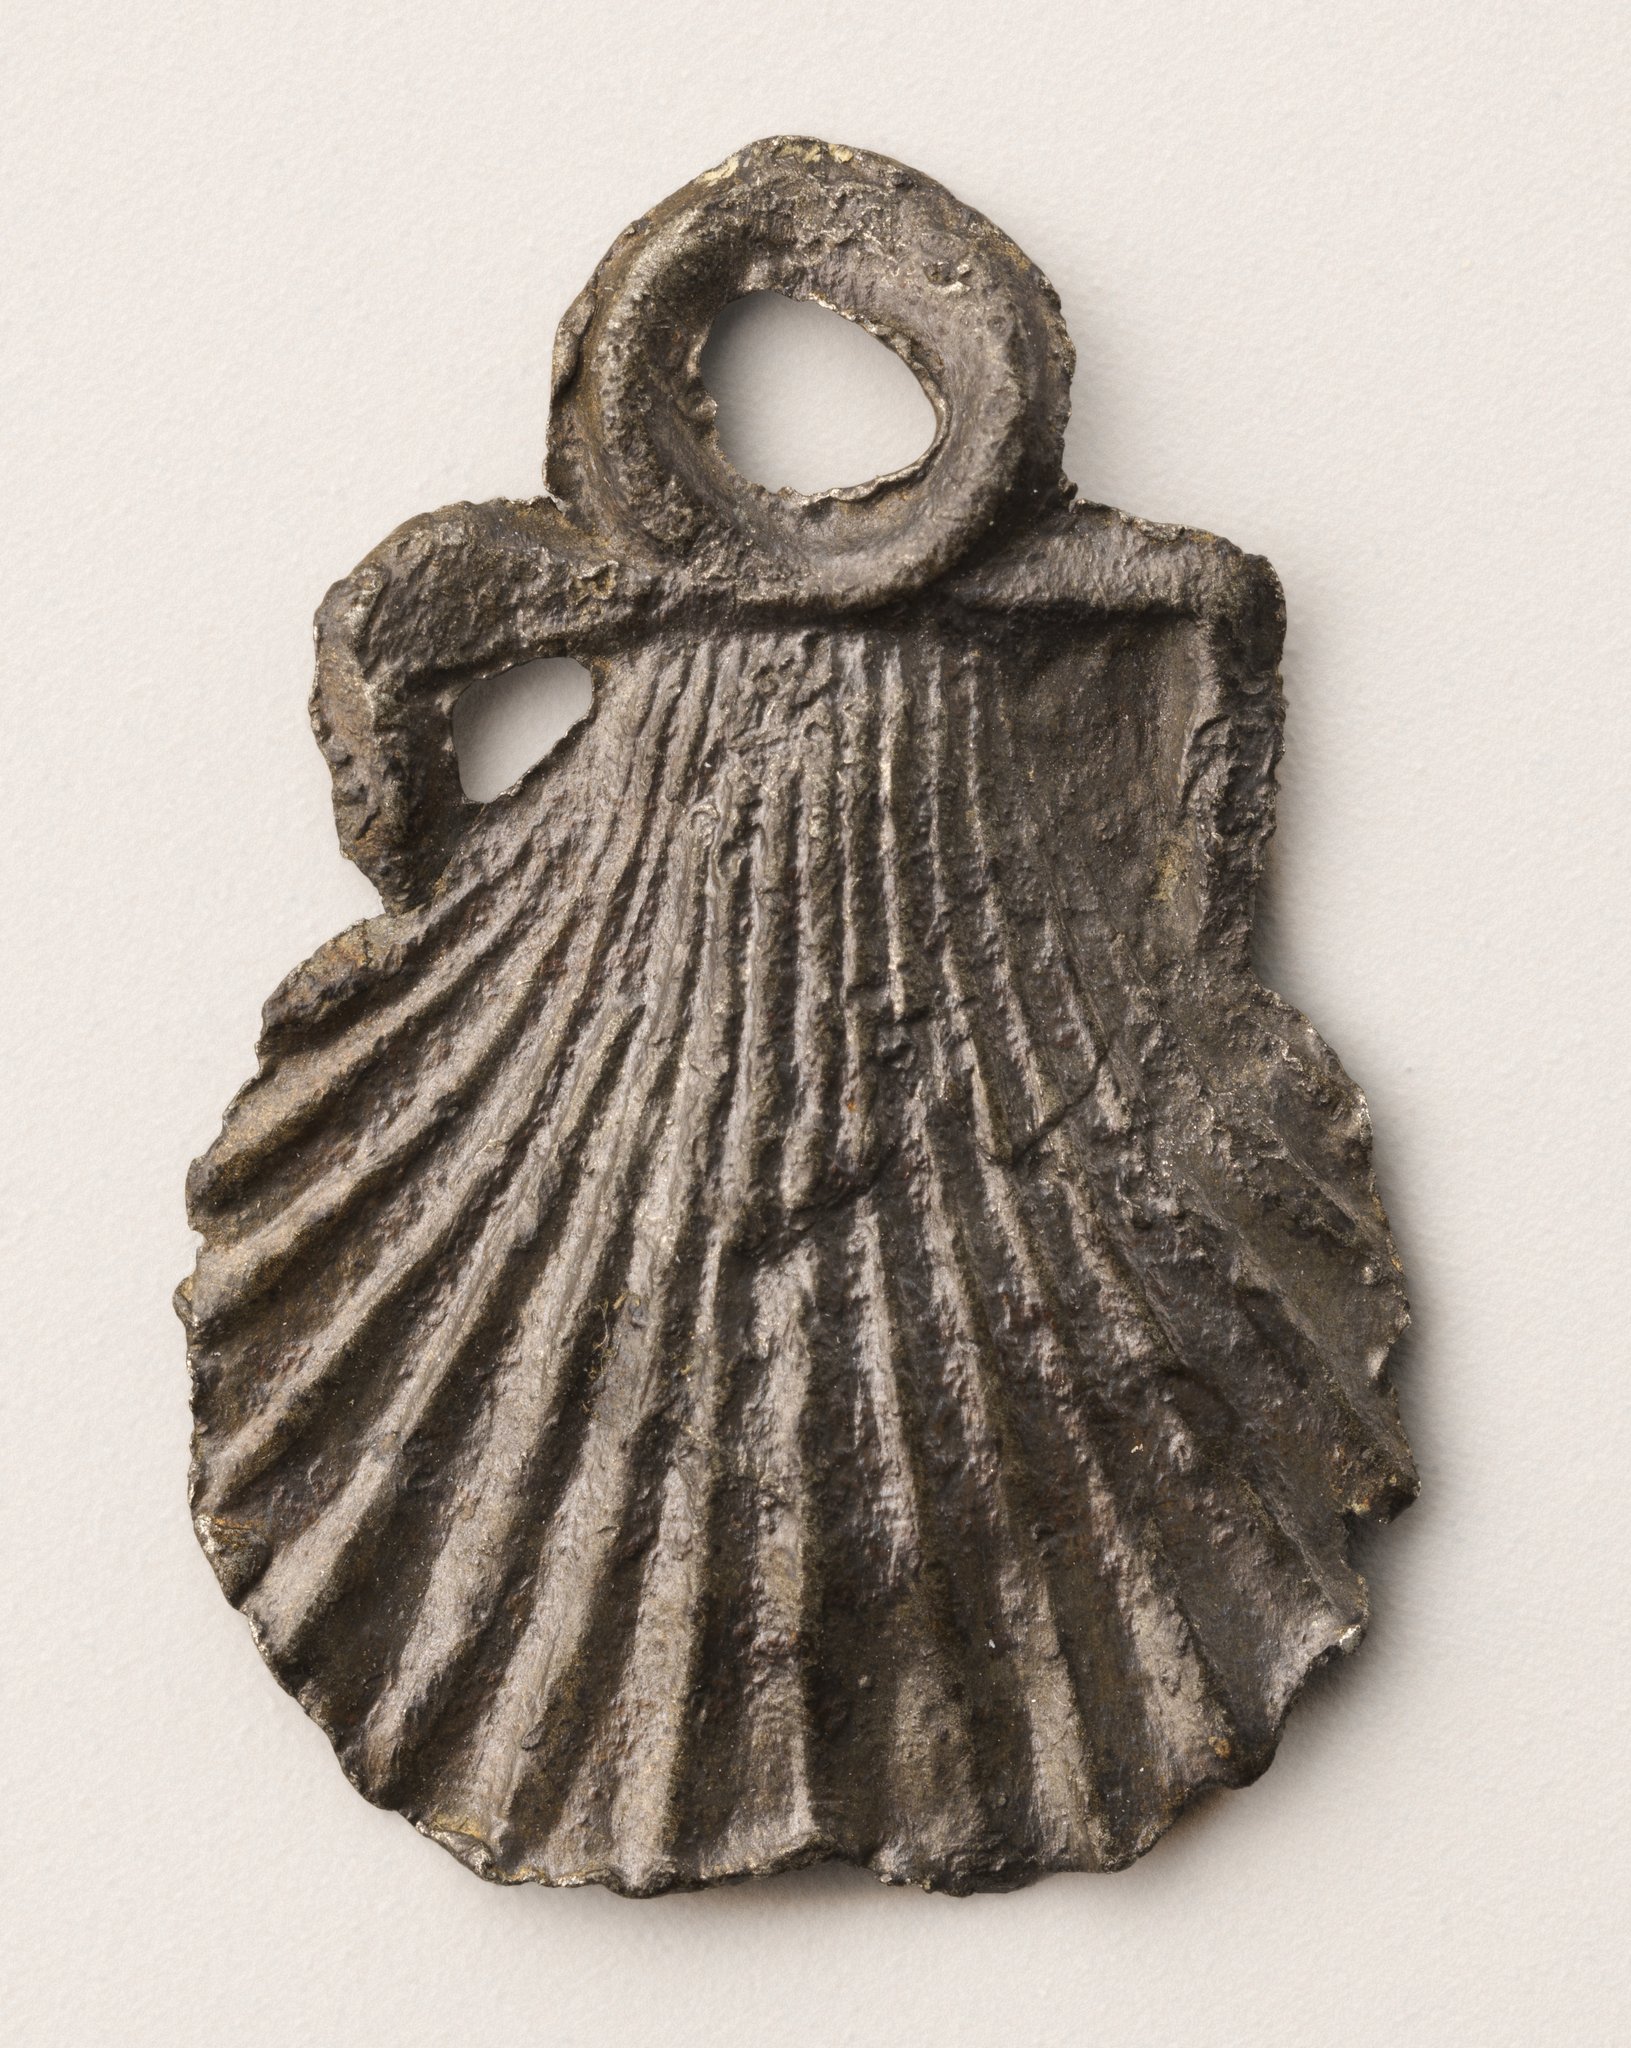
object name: pilgrim's badge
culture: french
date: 1401-1500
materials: lead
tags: shells